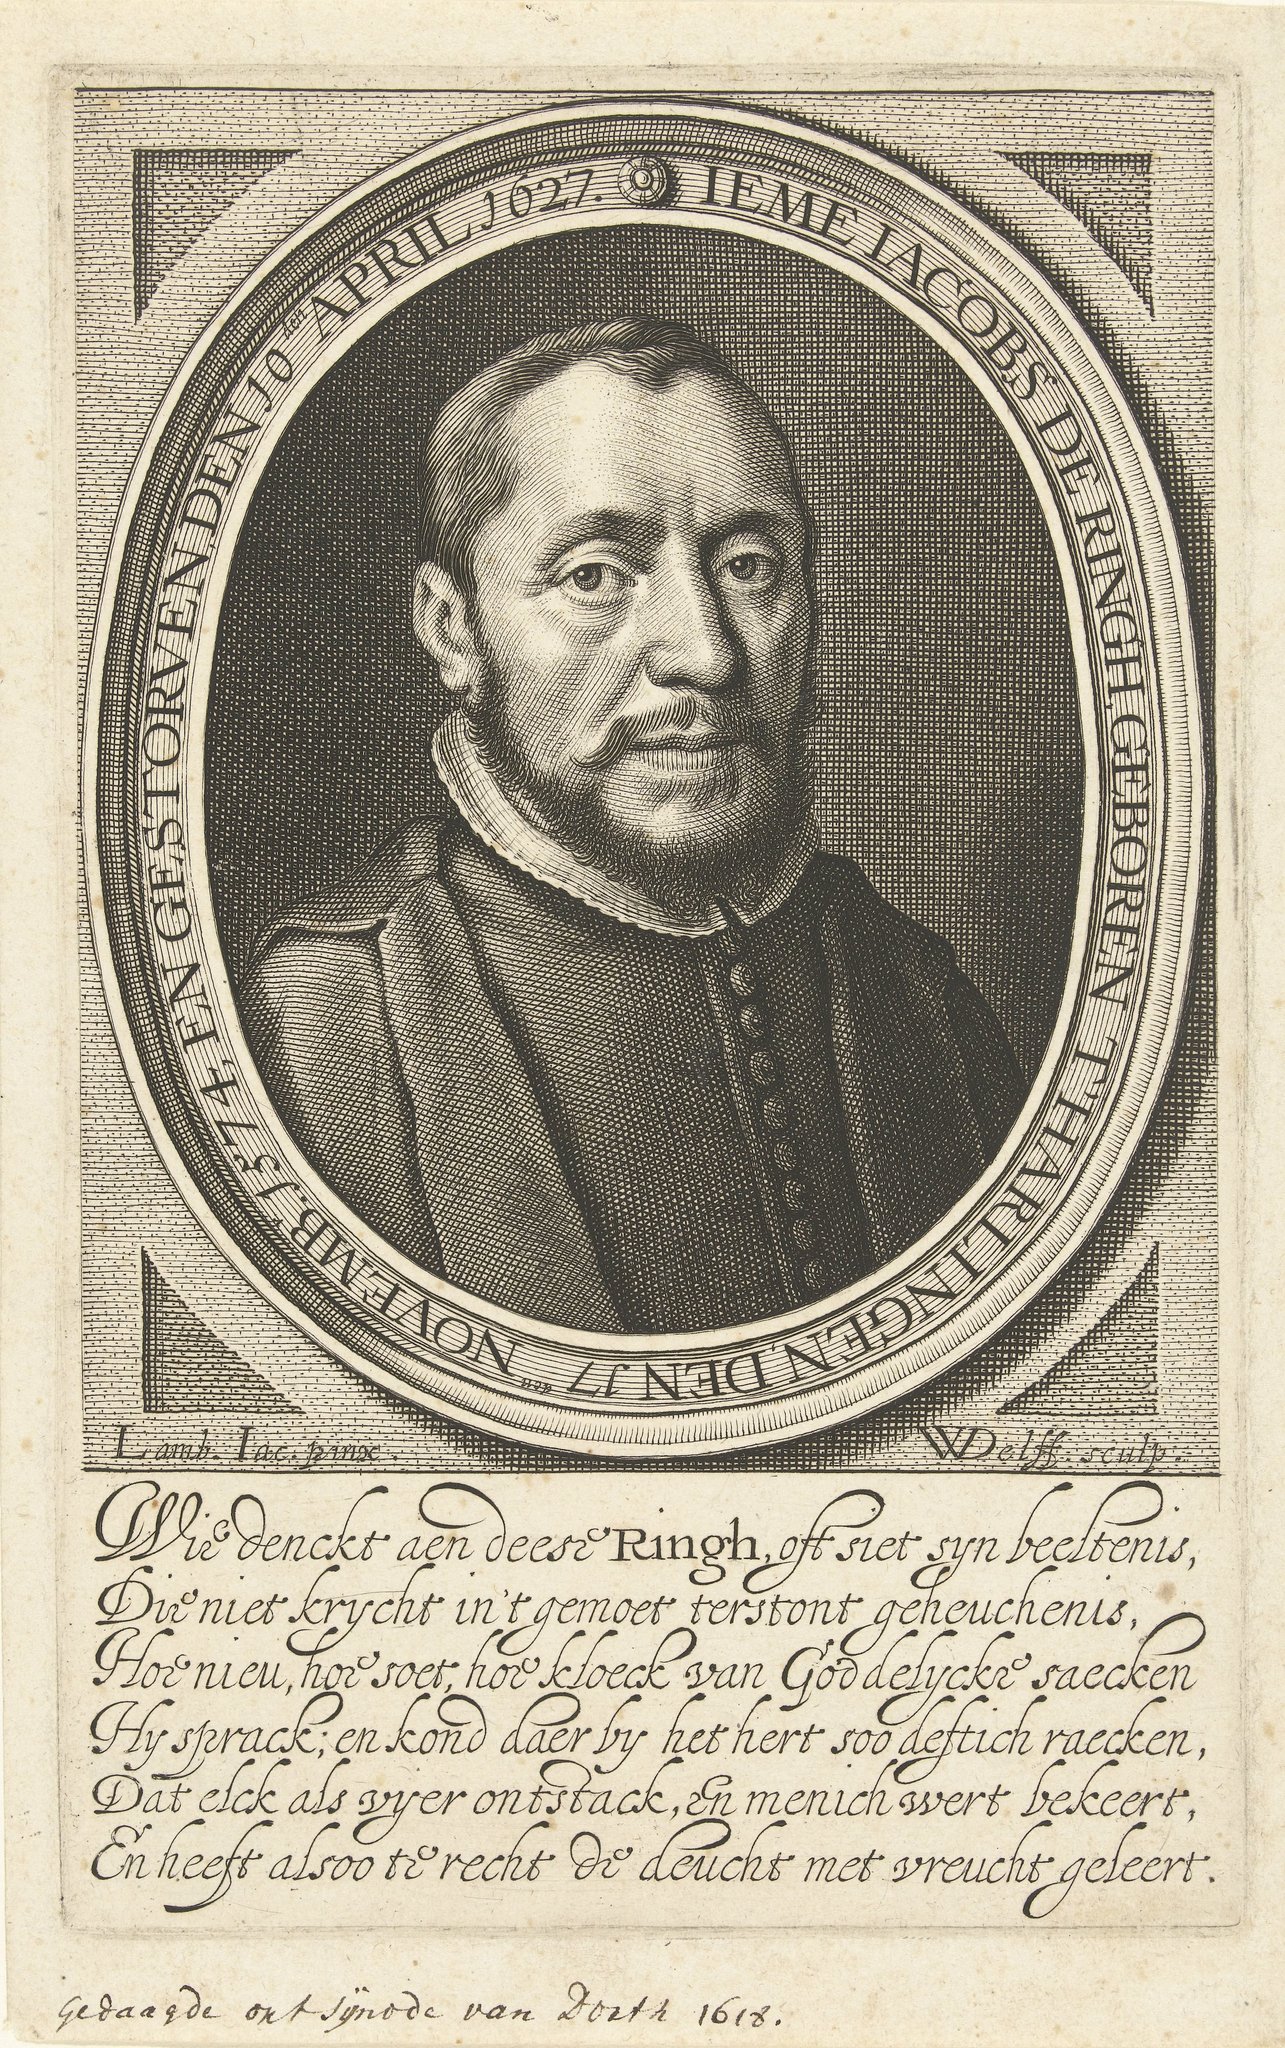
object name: print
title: Portret van Yeme de Ringh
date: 1627-1638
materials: paper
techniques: engraving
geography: delft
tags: harlingen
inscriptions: collector's mark: Lugt 2228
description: Portret van Yeme de Ringh, borststuk in sobere kleding in ovale omlijsting met Nederlands opschrift. In ondermarge Nederlands vers in zes regels.